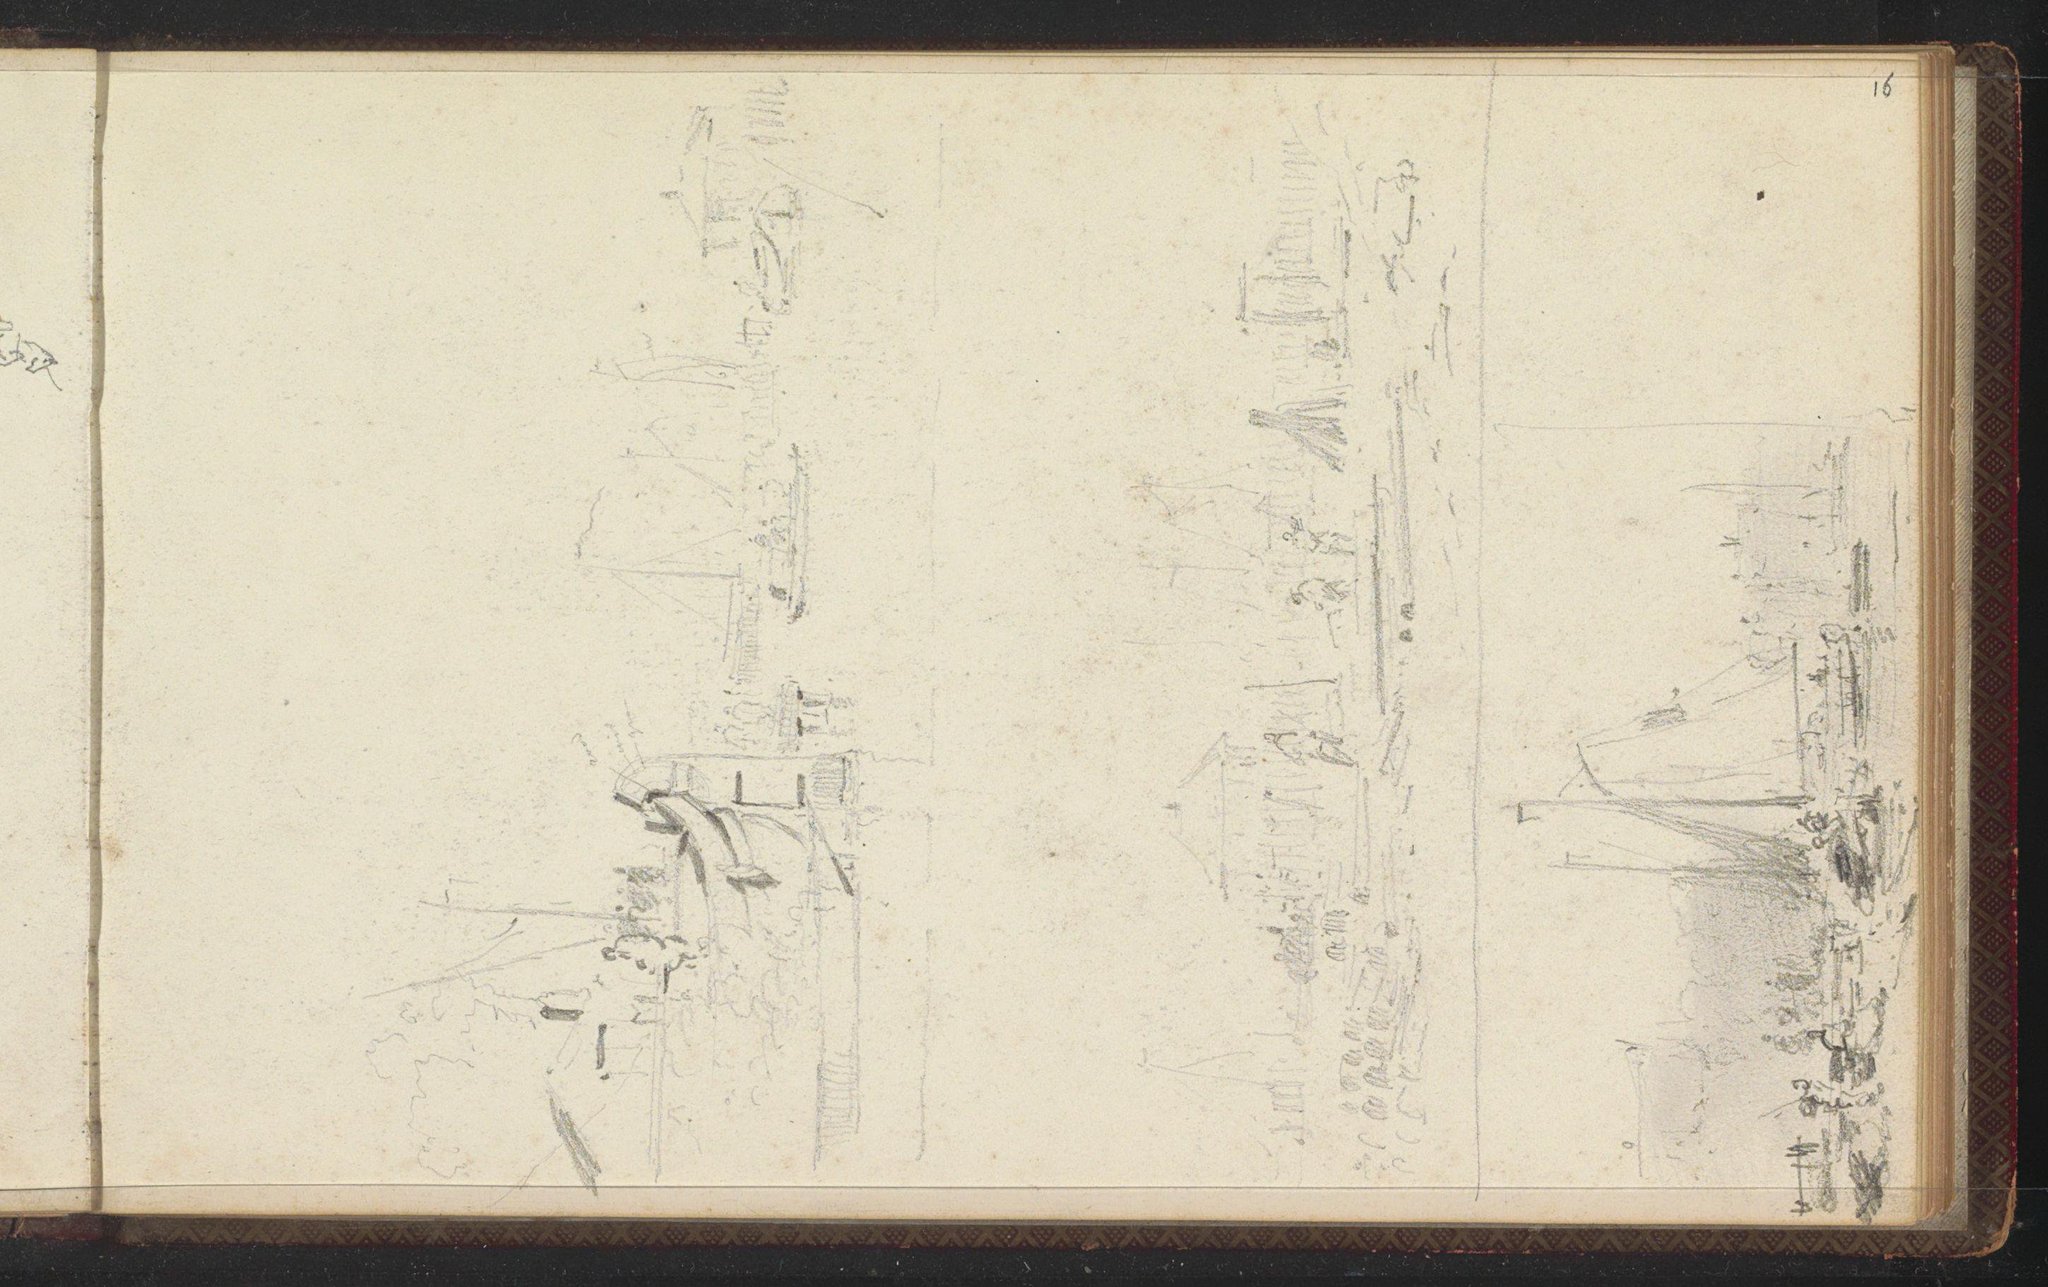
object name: sketchbook leaf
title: Drie landschappen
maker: adrianus eversen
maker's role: draughtsman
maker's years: 1818-1897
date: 1828-1897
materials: paper, pencil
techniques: stumping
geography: netherlands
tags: harbour, sailing-ship, sailing-boat, landscapes with waters, waterscapes, seascapes (in the temperate zone)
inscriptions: kleurnotitie, handgeschreven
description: Boven zeilschepen in een haven. In het midden een landschap met arbeiders bij hout. Op de achtergrond zeilschepen. Onder een aanlegplaats voor boten. Blad 16 uit een schetsboek met 52 bladen vervaardigd in de omgeving van Kampen, Hattem, Hoorn en Zwolle.